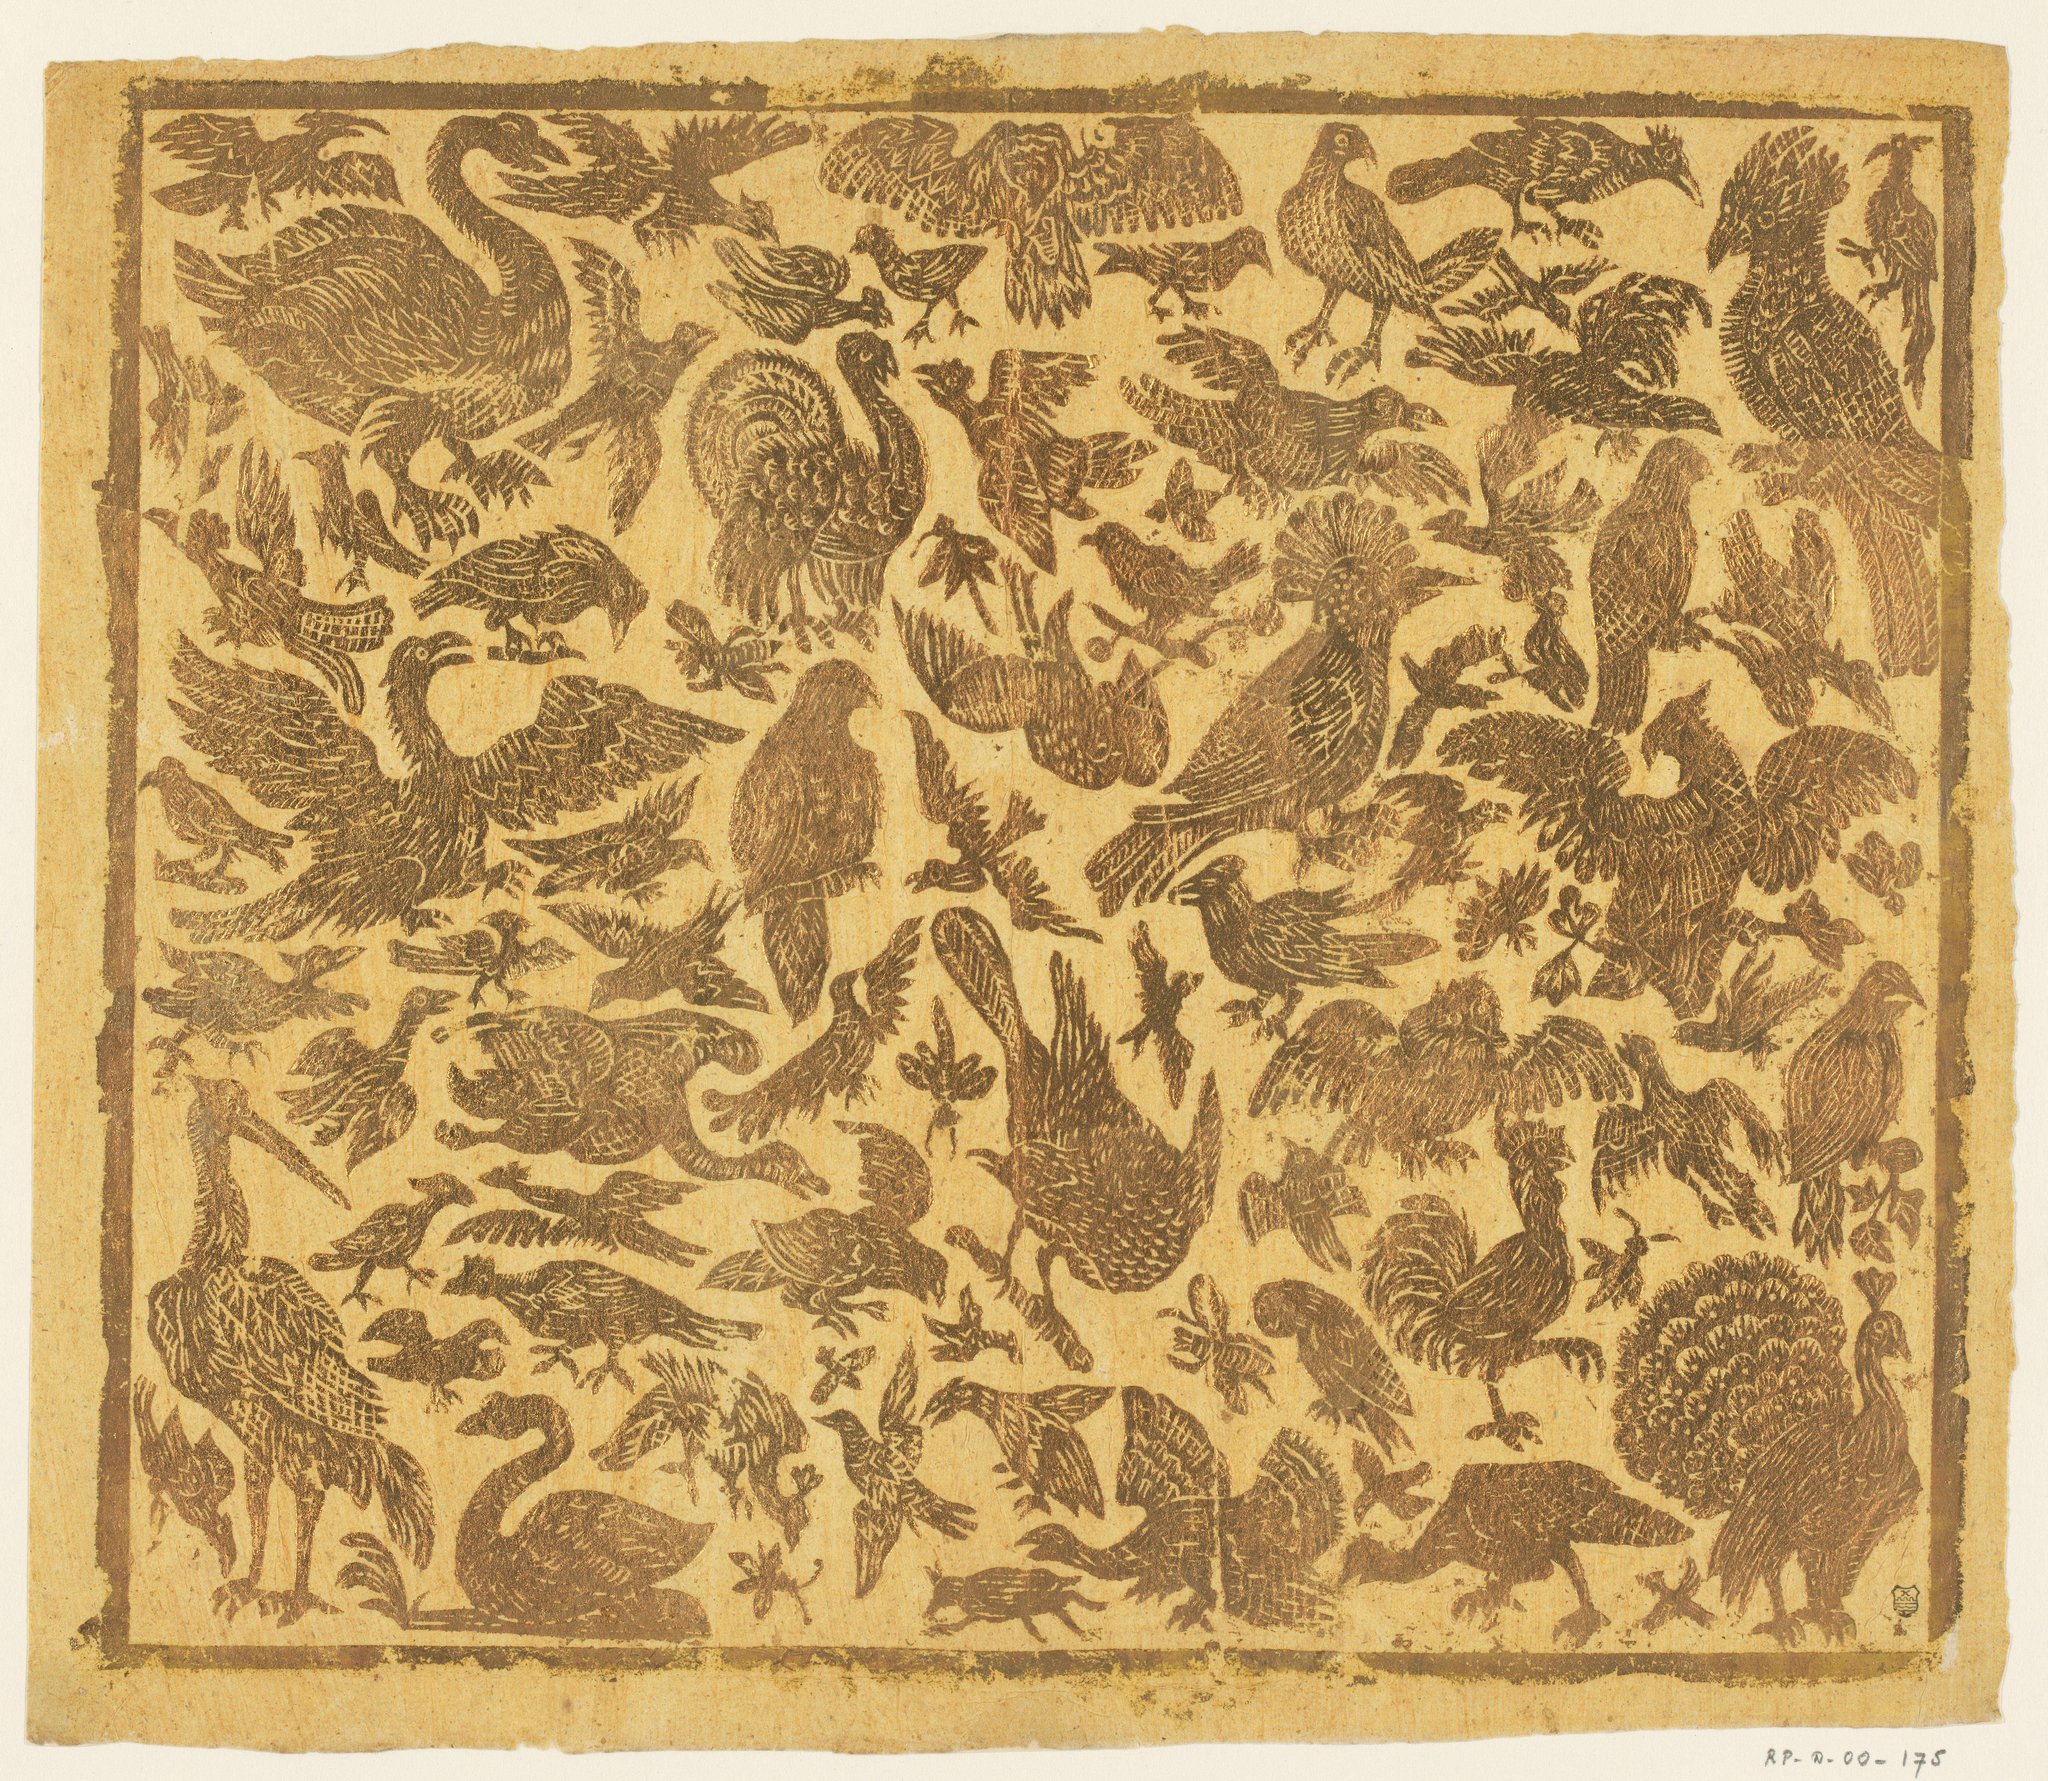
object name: brocade paper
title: Blad met vogels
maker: Anonymous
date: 1740-1750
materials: gold leaf, paint, paper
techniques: relief print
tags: birds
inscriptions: collector's mark: Lugt 2760, collector's mark: Lugt 2228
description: Blad met vogels, linksboven een zwaan, rechtsboven kaketoe, linksonder een reiger, rechtsonder pauw.